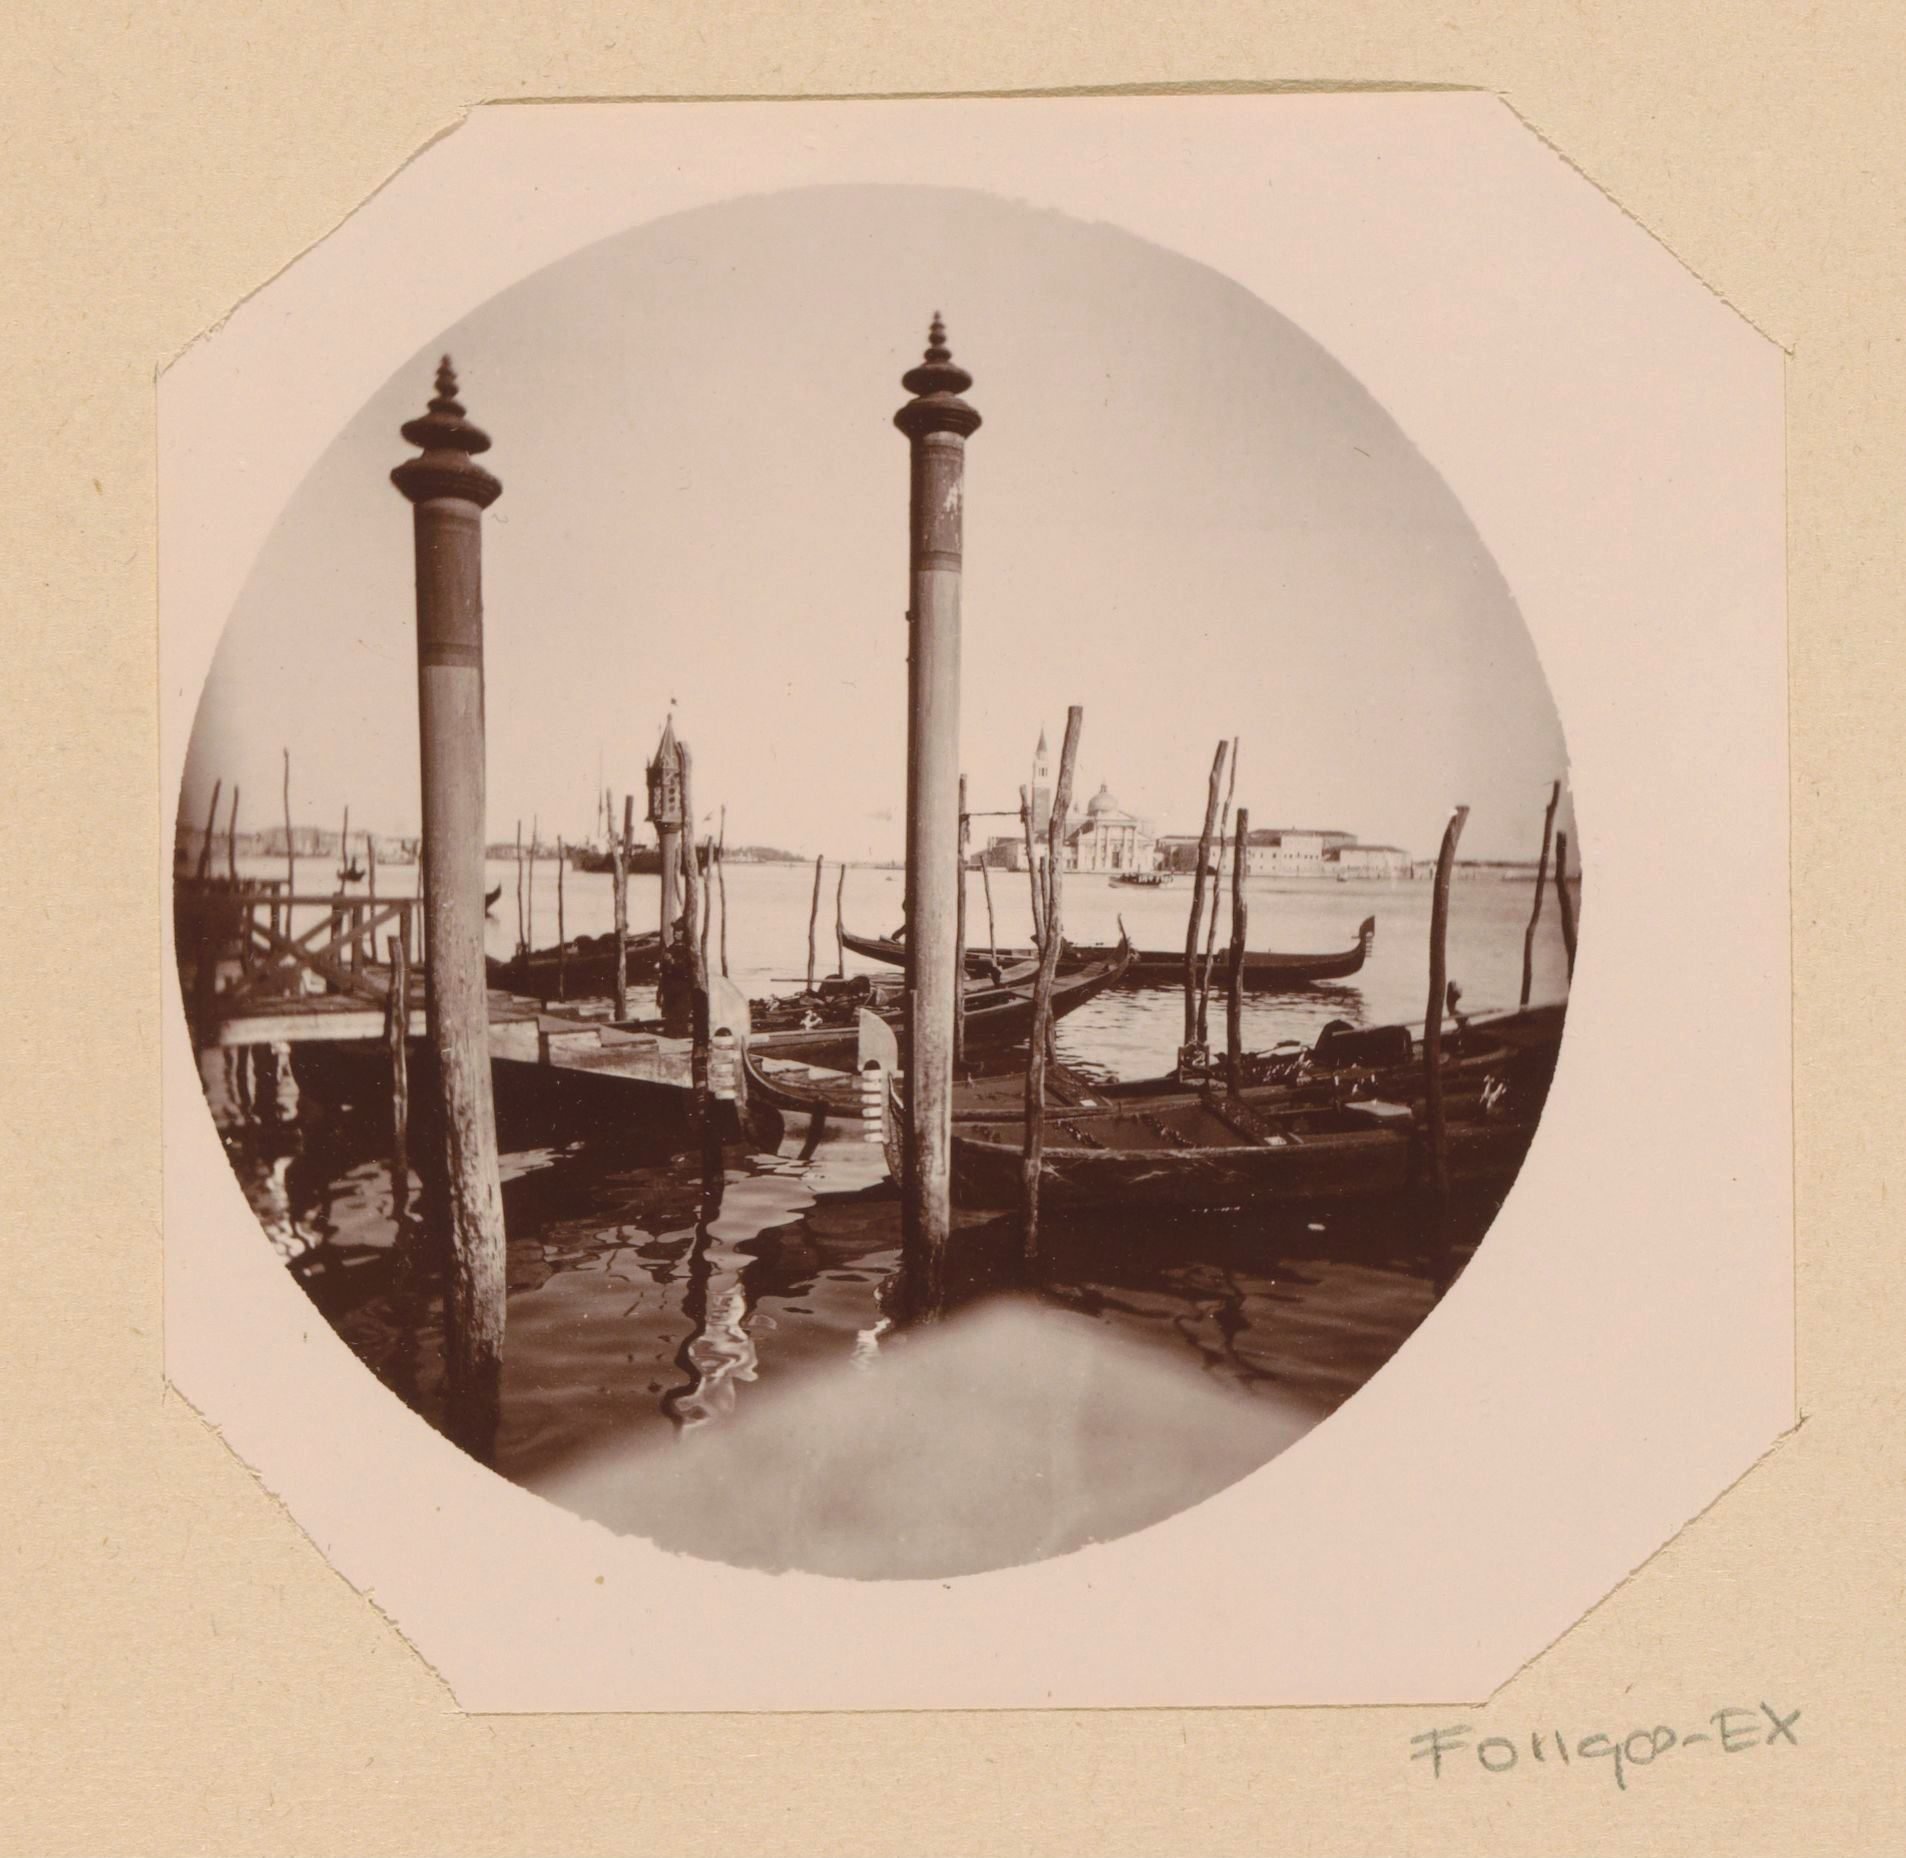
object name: album leaf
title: Snapshots with a Kodak no. 2 in Venice, Warnemünde, Warnsborn, and Amsterdam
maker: johanna margaretha piek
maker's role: fotograaf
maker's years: 1870-1947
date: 1889-1893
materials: paper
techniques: gelatin silver print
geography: venice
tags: gondola